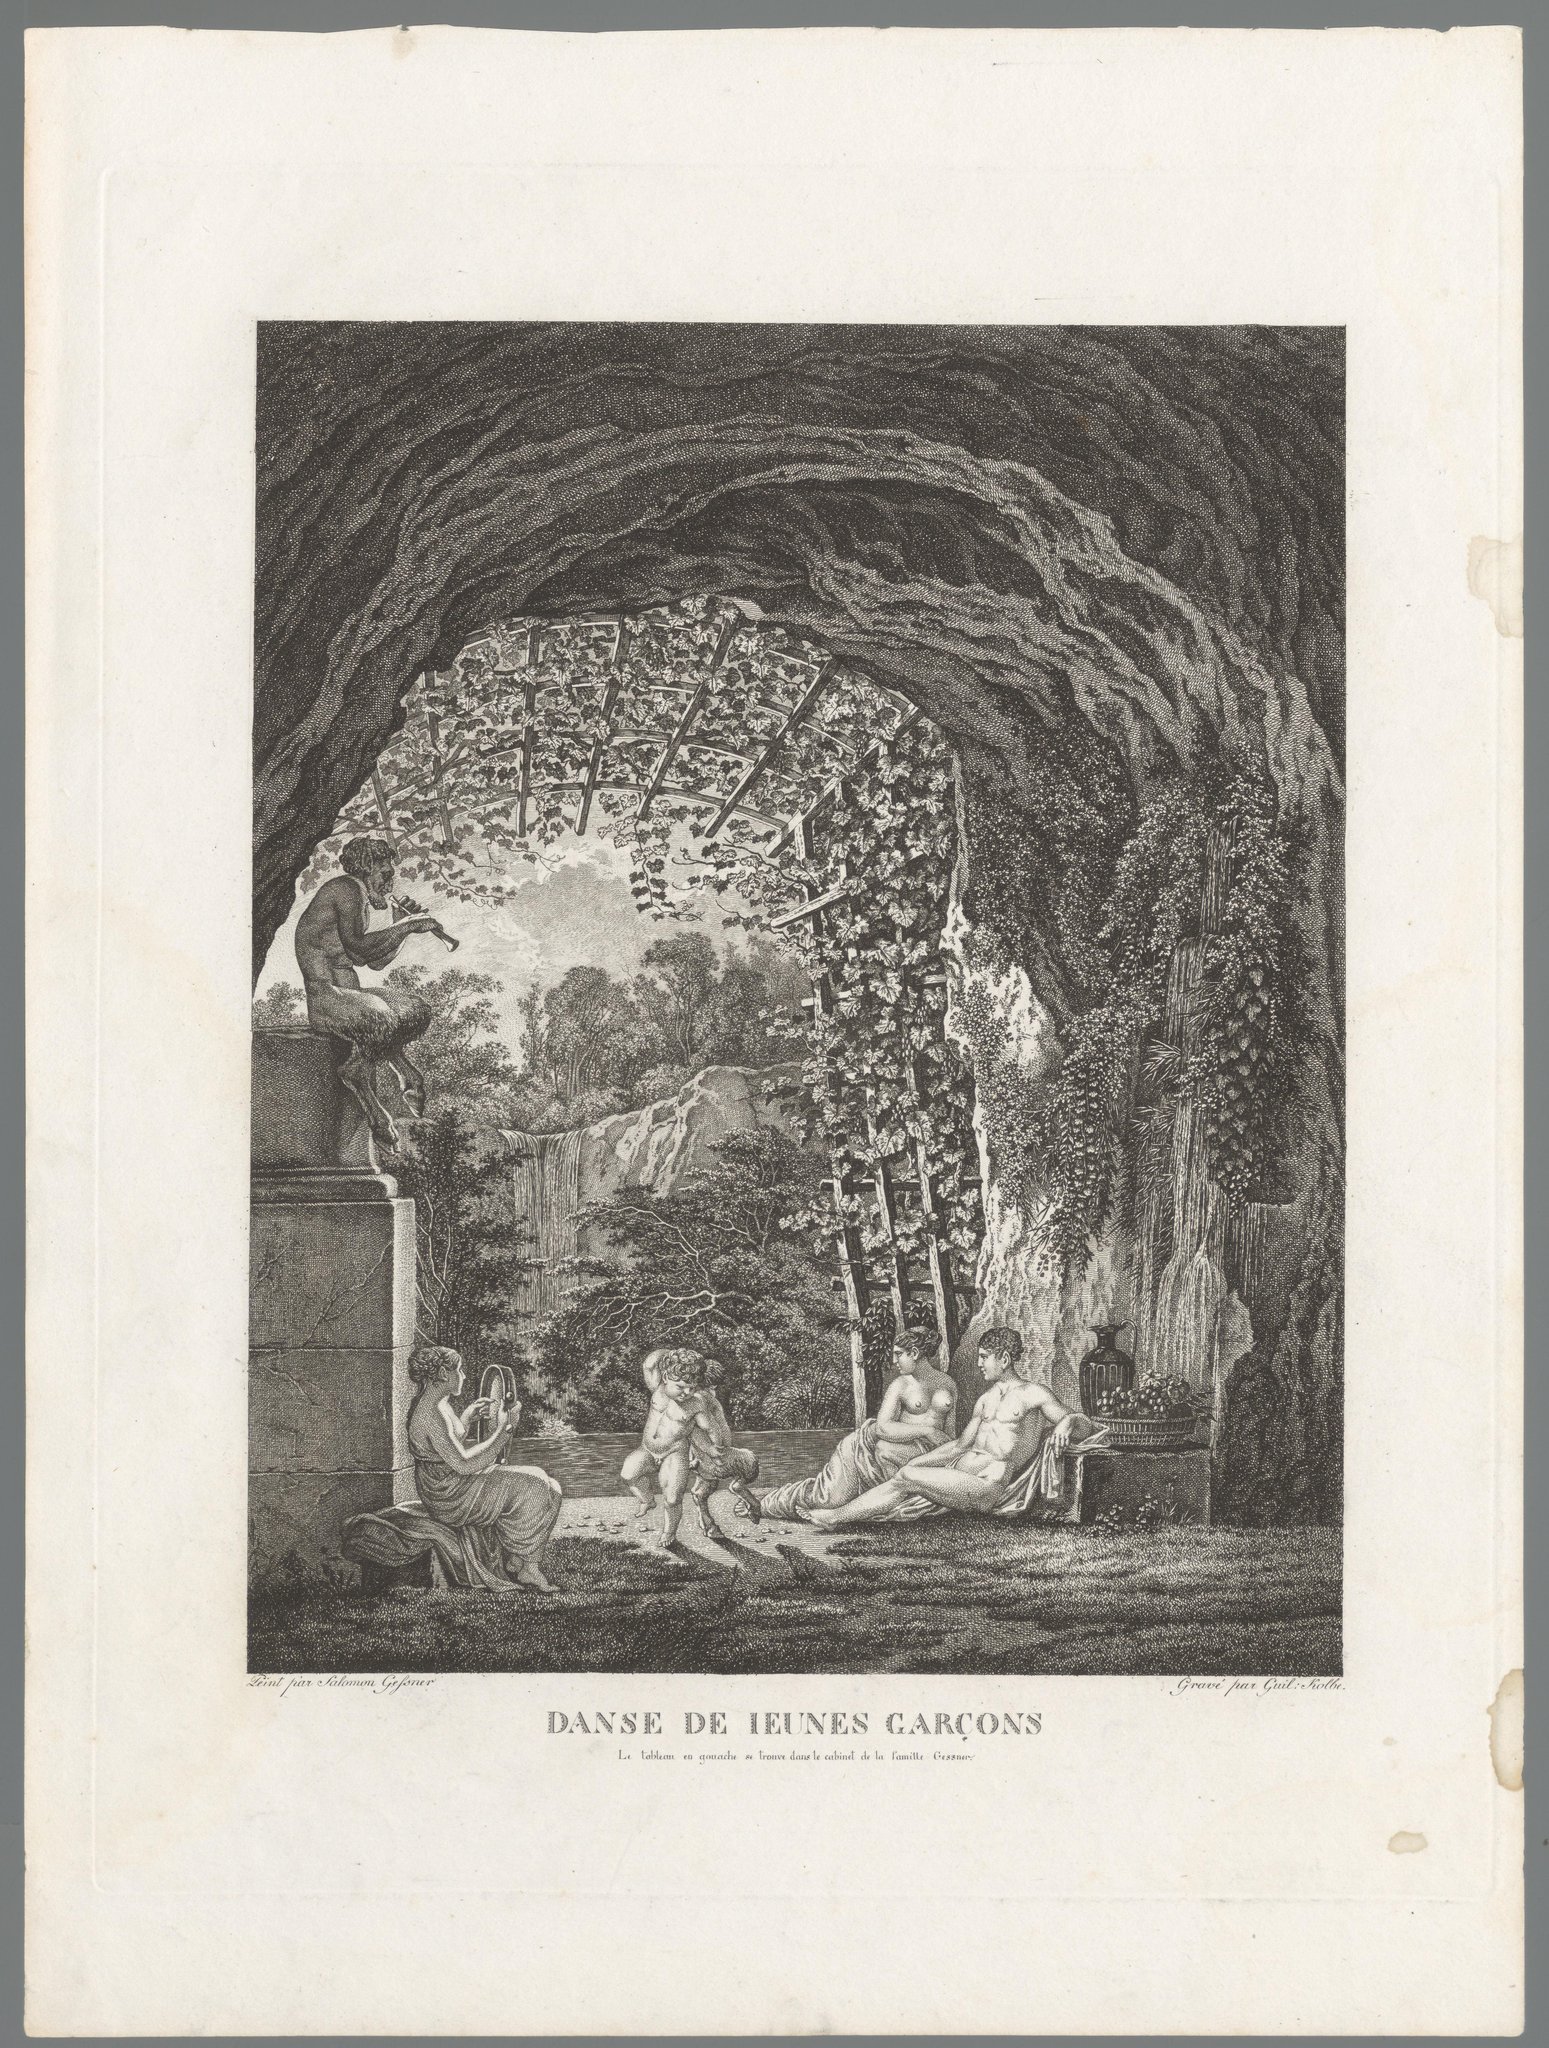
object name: print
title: Collection des tableaux en gouache et des dessins de Salomon Gessner. Gravés à l'eau forte par Guil. Kolbe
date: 1811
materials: paper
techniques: etching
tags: cave, grotto - hh - ideal landscapes, non-aggressive, friendly or neutral activities and relationships of satyr(s), nymphs (in general); 'ninfe in commune' (ripa), more than one musician with instrument - cc - 'concert champêtre', pastorals, arcadian scenes, dancing games (children's games)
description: Twee saters en vier nimfen zitten in een grot met daarvoor een pergola met wijnranken en zicht op een waterval. Tekst in het Frans in de ondermarge. Deze prent maakt deel uit van een omslag met 27 losse bladen, waarvan 25 prenten, een titelblad en een tekstblad.